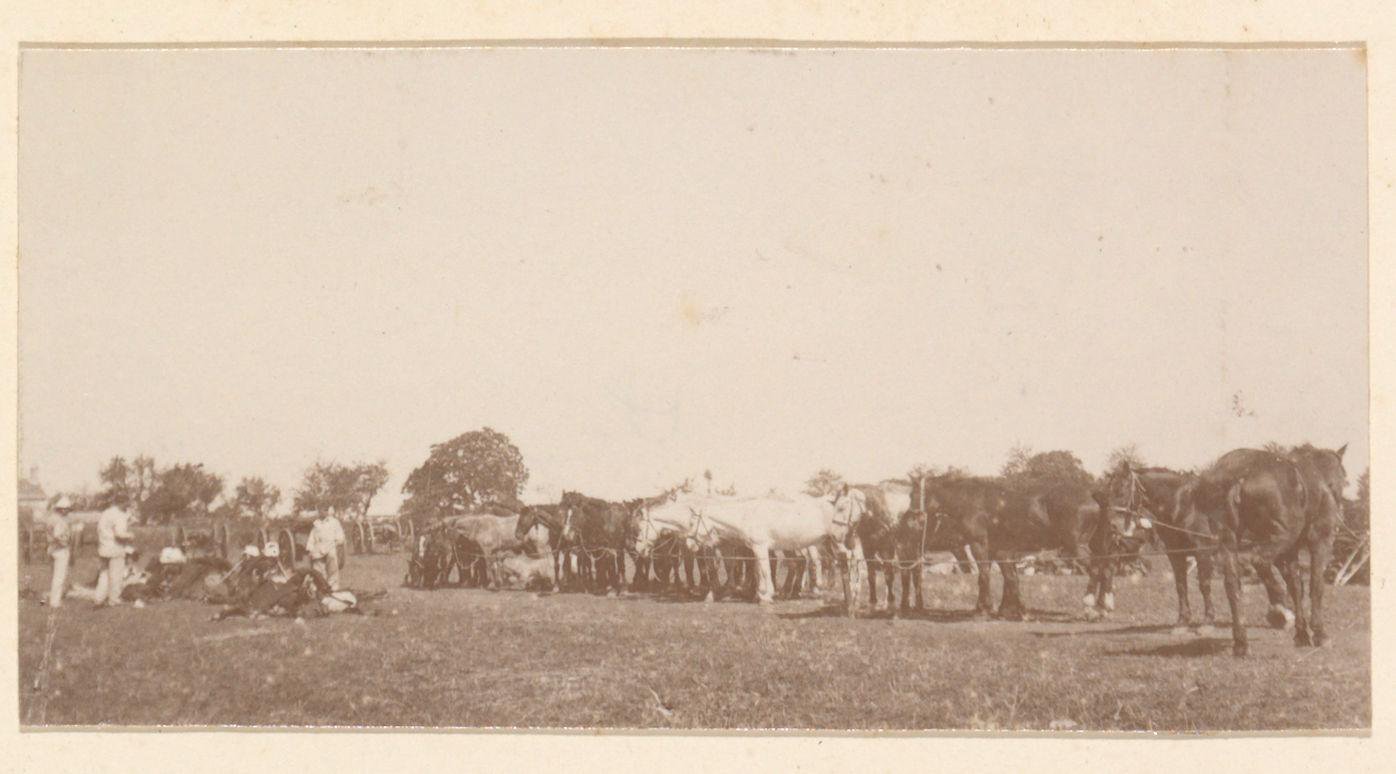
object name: photograph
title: Paarden van een Frans legeronderdeel op een grasveld in Frankrijk, links militairen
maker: Anonymous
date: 1900-1910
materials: paper, photographic support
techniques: albumen print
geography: france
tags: land forces (+ cavalry, horsemen), horse, france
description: Onderdeel van Fotoalbum van een Franse amateurfotograaf met opnames van een familie, distilleerderij Delizy & Doistau Fils, het leger en bezienswaardigheden in Frankrijk.